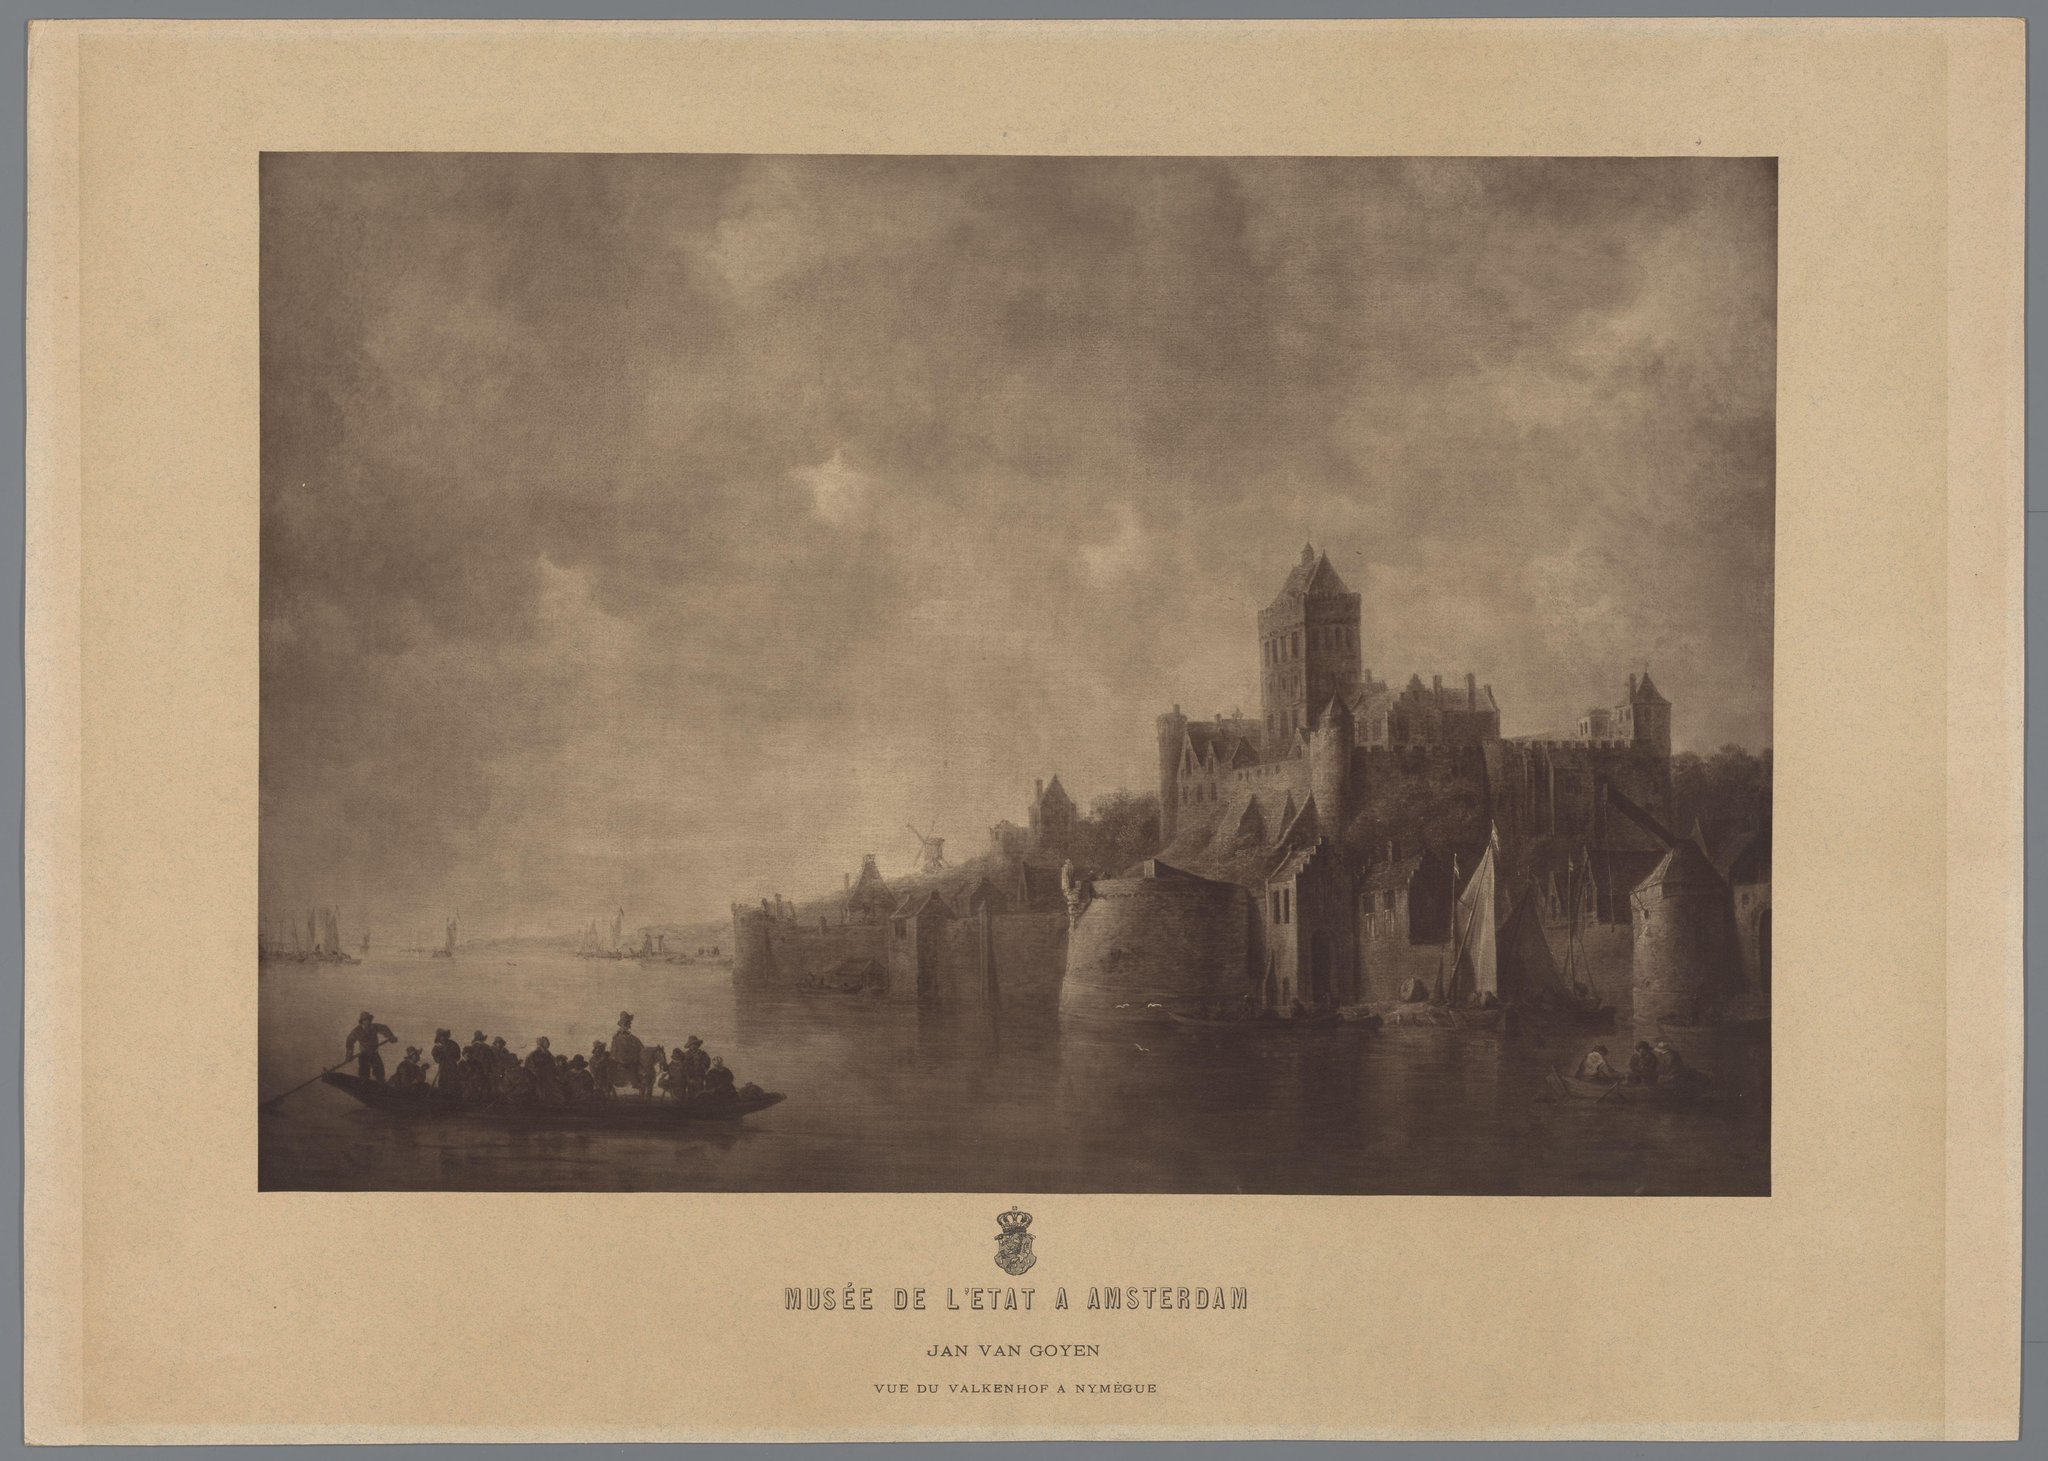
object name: photograph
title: Fotoreproductie van een schilderij van Jan van Goyen, 'Het Valkhof in Nijmegen' SK-A-122, (coll. Rijksmuseum)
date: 1880-1900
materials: cardboard, paper, photographic support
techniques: carbon print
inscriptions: signature and date: ‘Photo-chromie inaltérable / Brevté S.G.D.G. / [monogram] AP’